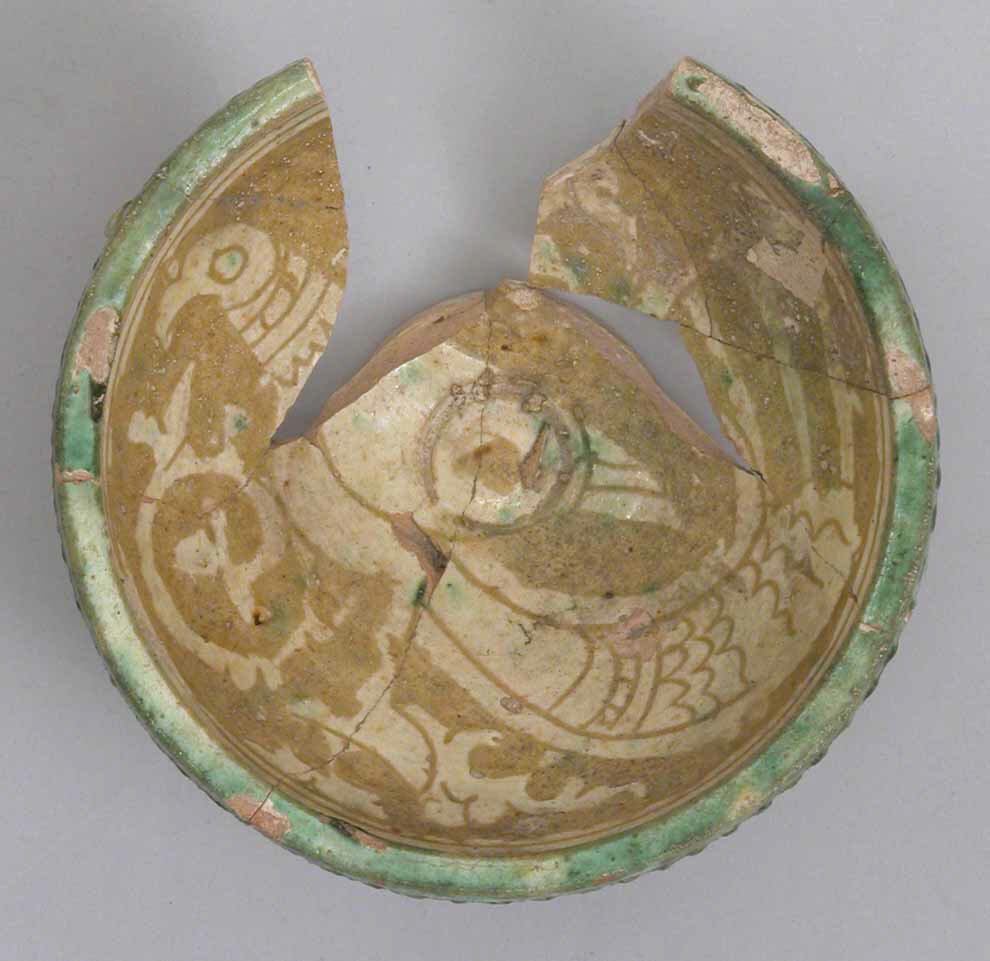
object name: bowl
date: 1101-1200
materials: earthenware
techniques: carving, glazing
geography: syria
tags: birds